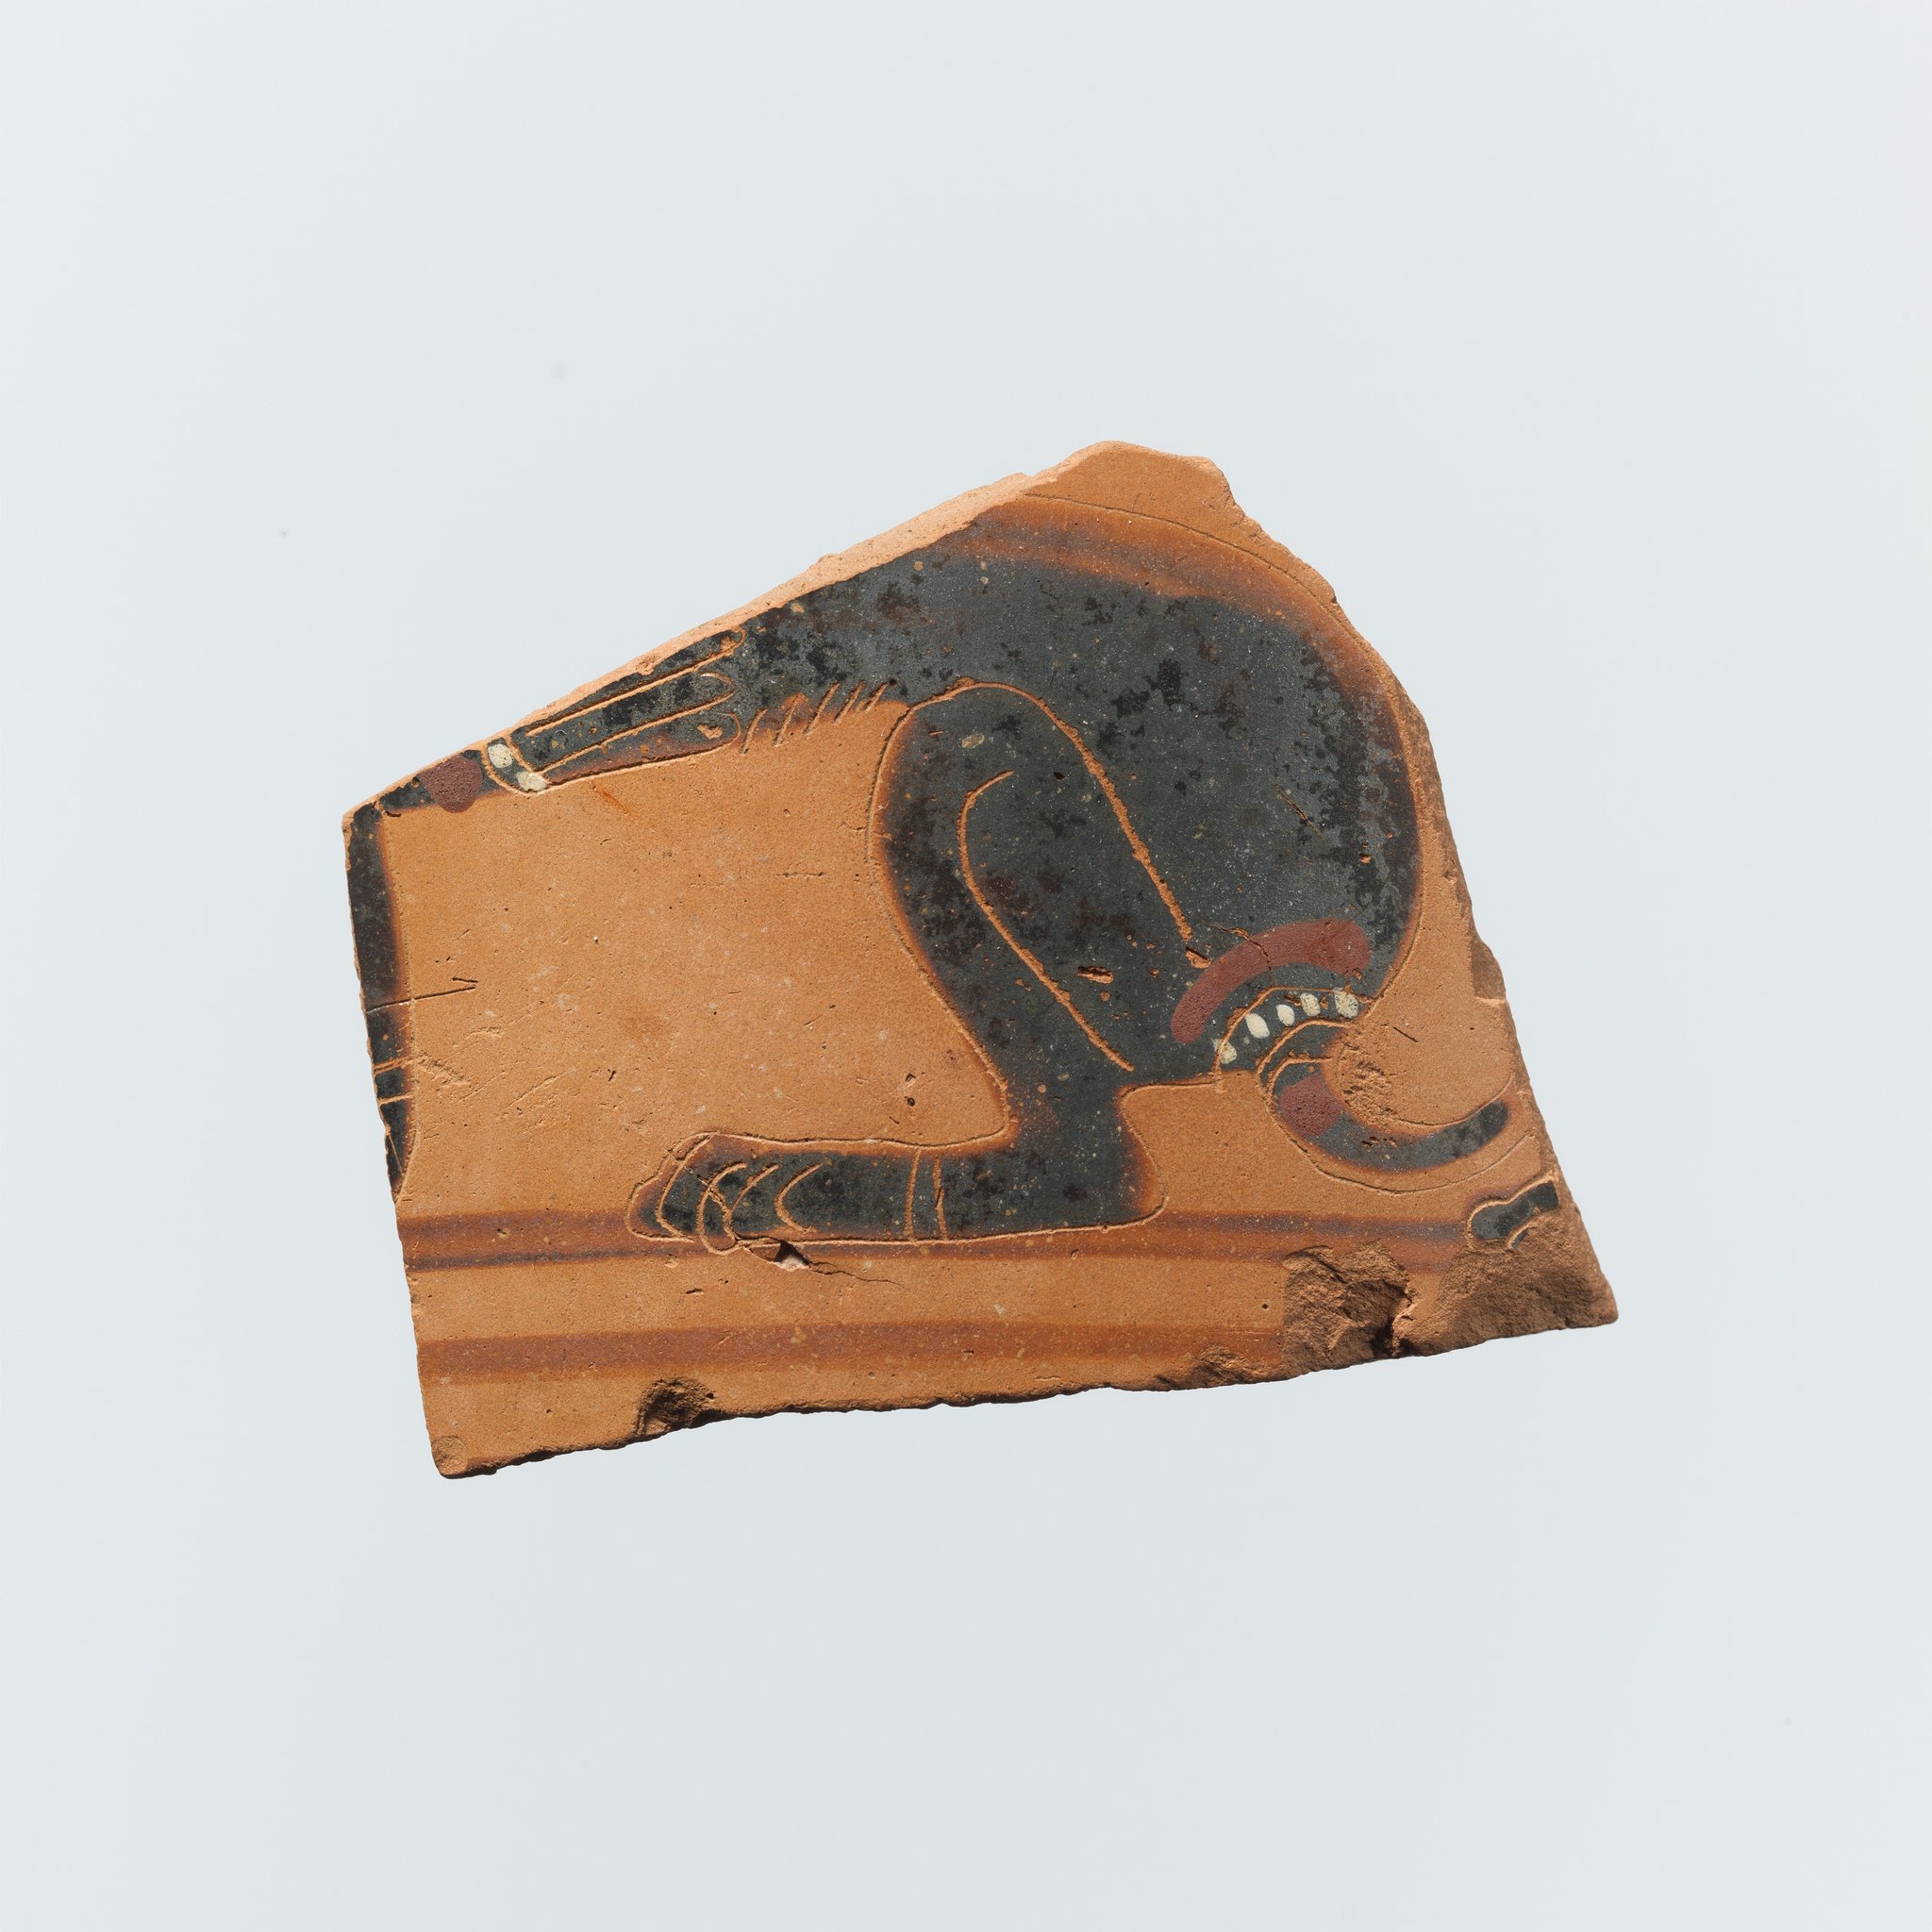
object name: neck amphora fragment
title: Fragment of a terracotta neck-amphora (jar)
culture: greek, east, clazomenian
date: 600-501 BCE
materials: terracotta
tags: sphinx